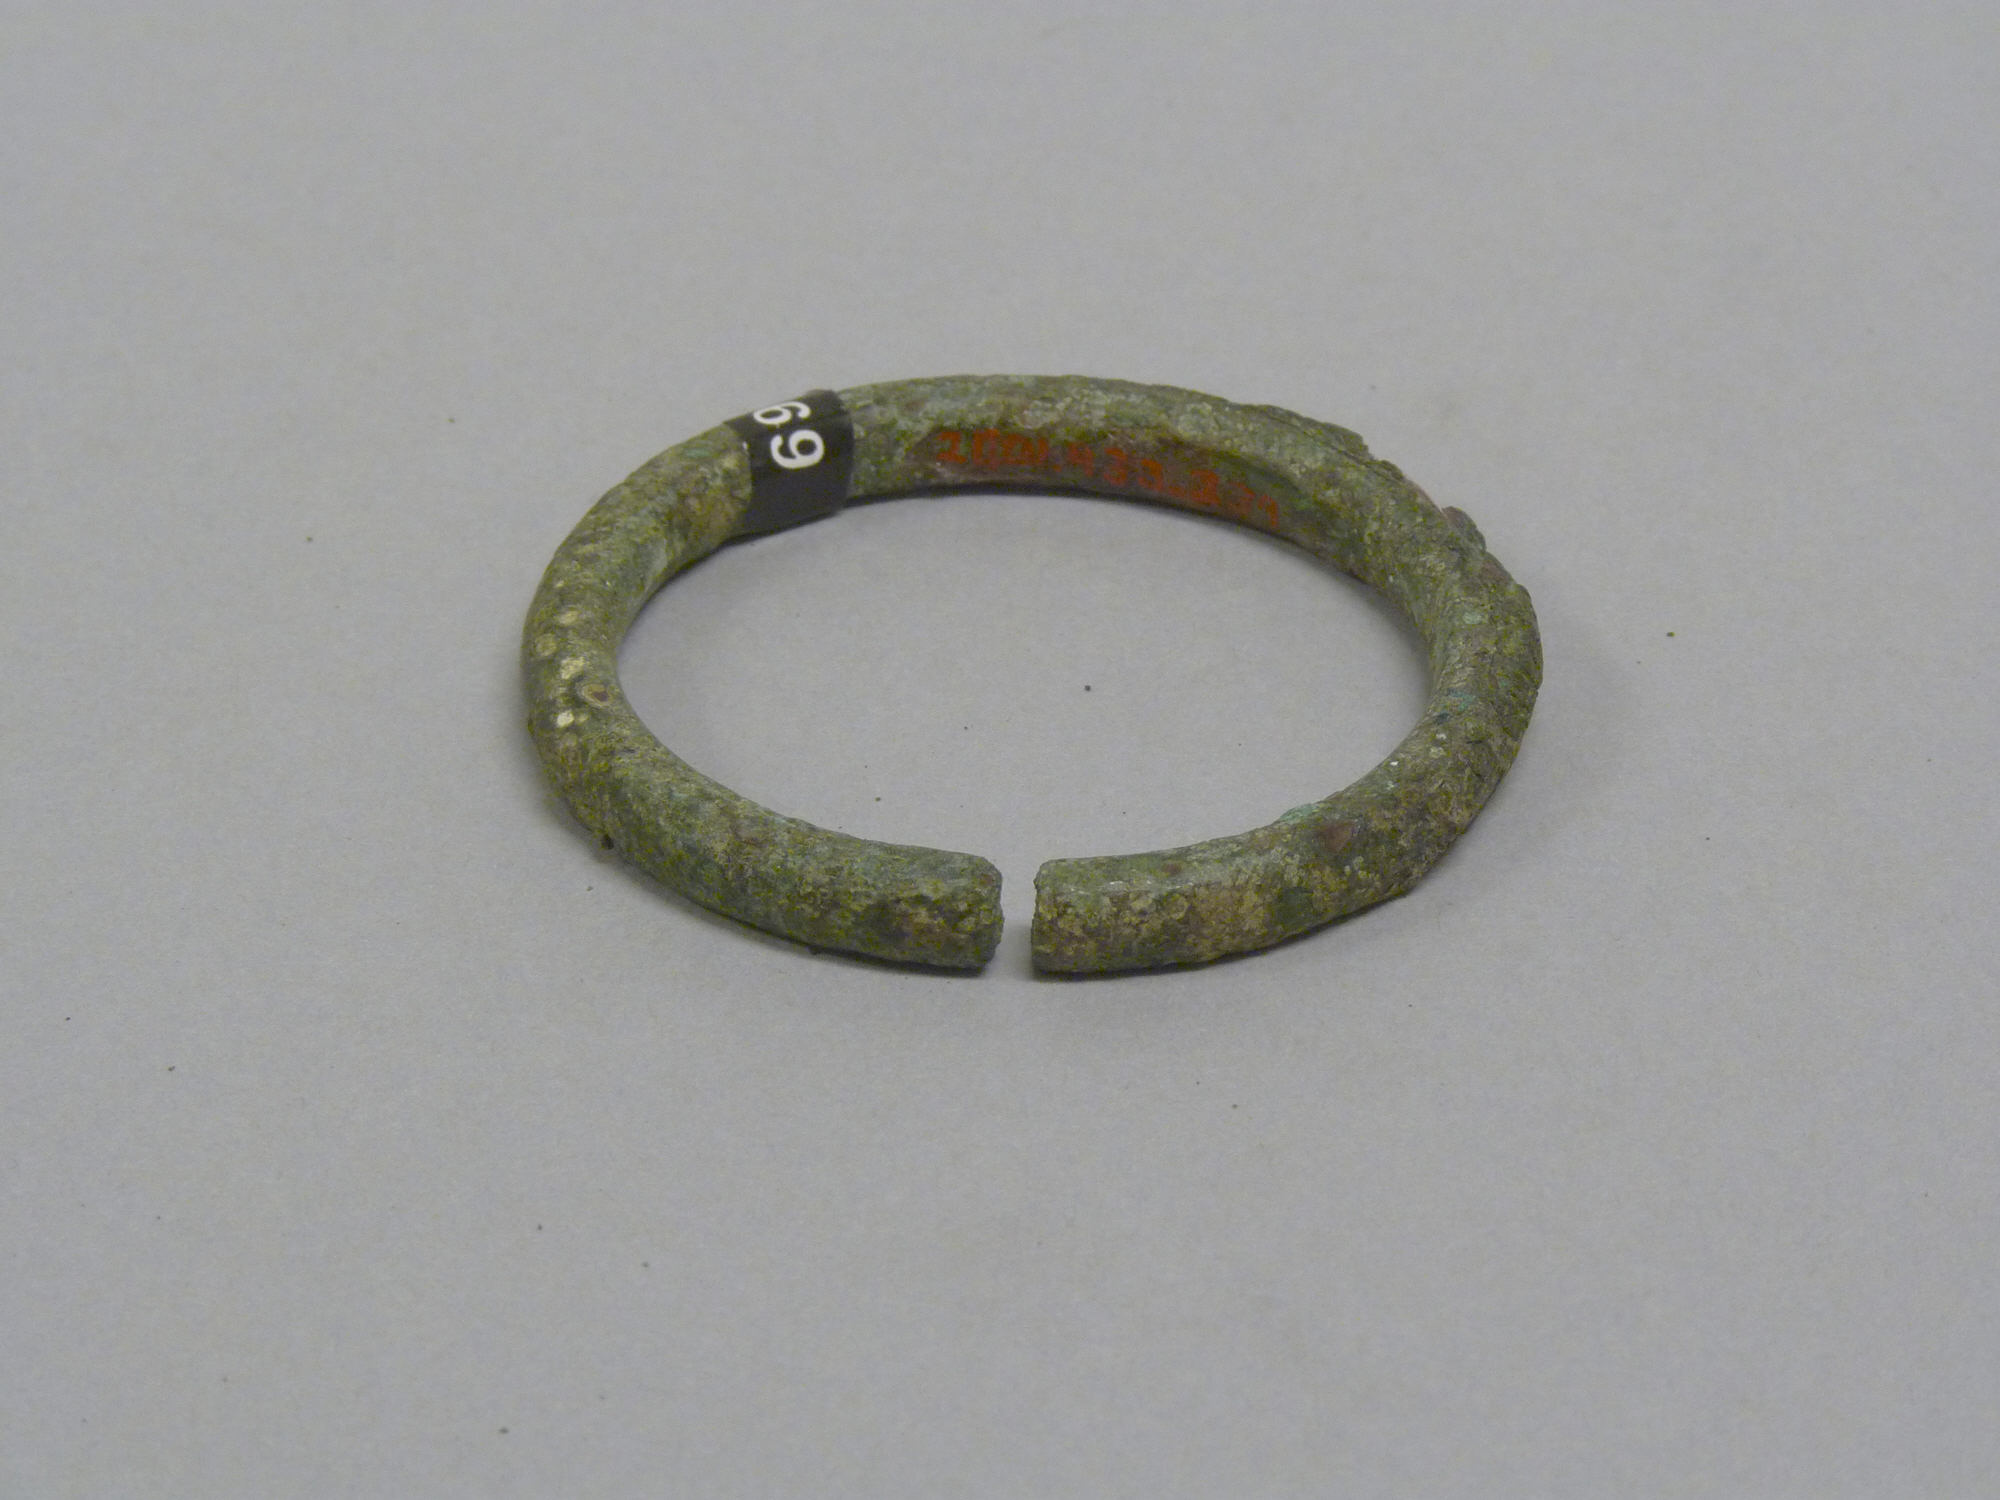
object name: solid undecorated bangle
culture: thai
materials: bronze